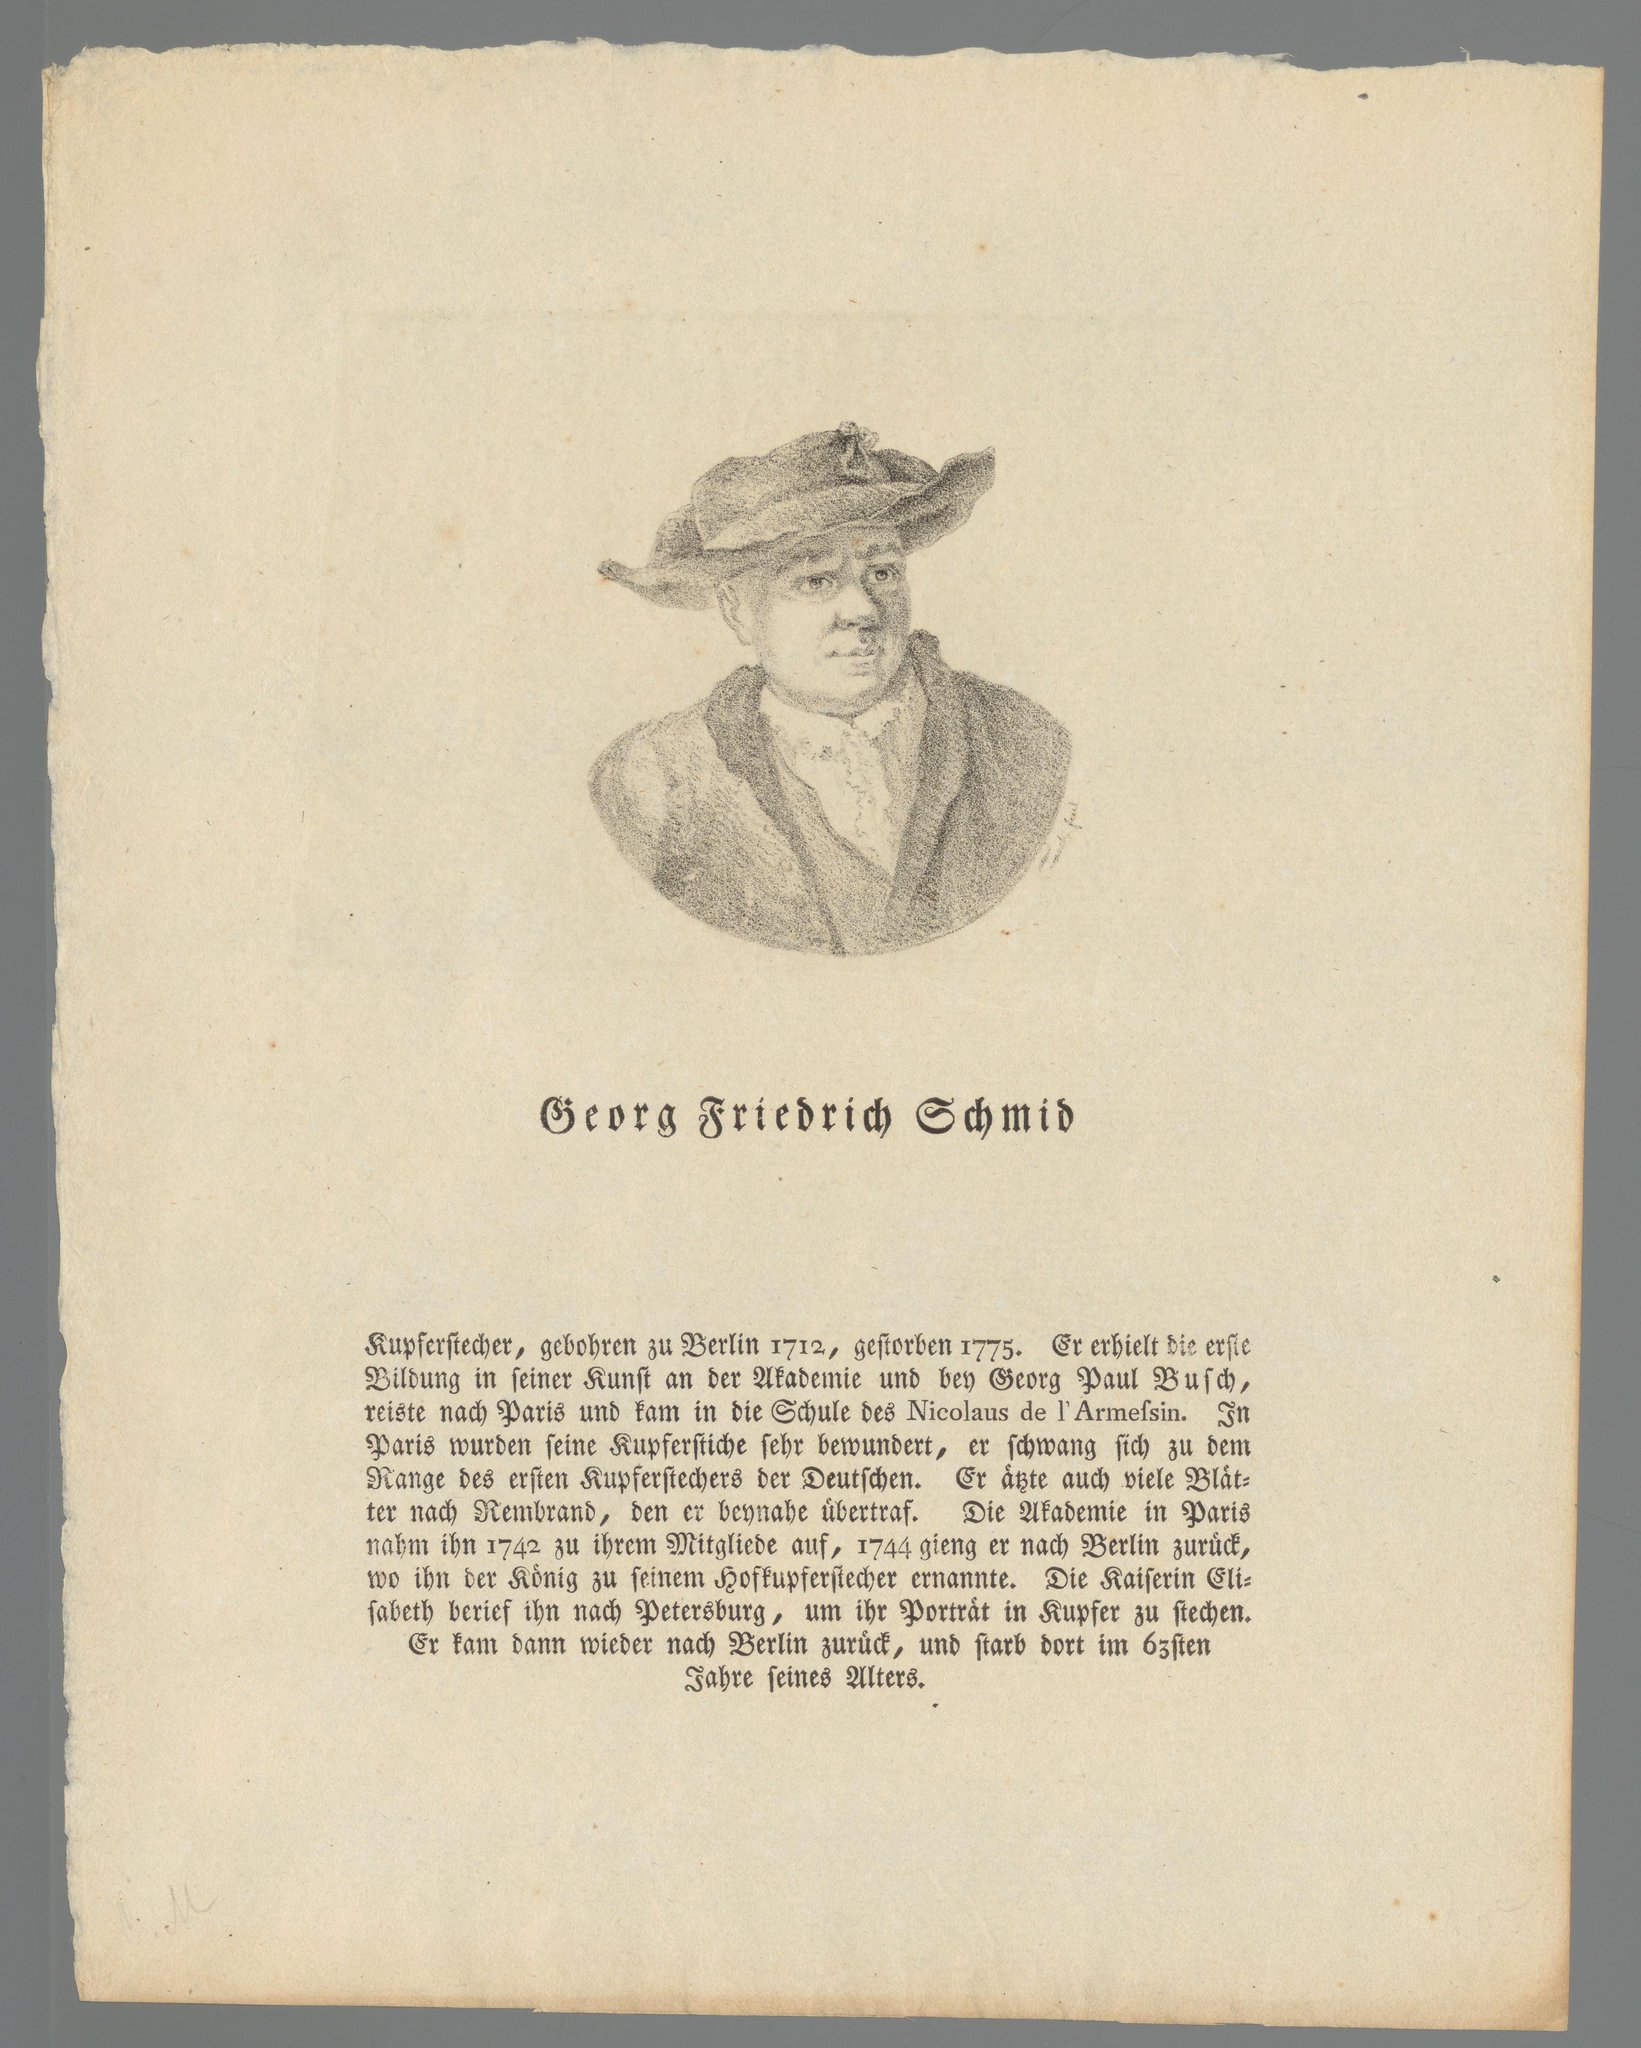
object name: print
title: Portret van Georg Friedrich Schmidt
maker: maximilian franck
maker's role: print maker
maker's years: 1780-1830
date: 1813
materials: paper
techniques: letterpress printing, lithograph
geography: munich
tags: berlin, print maker, draughtsman, georg friedrich schmidt, historical persons, portrait, self-portrait of graphic artist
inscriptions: collector's mark: Lugt 2228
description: Prent uit: Lindauer, Joseph. Deutsche Künstler-Gallerie. München: Maximilian Franck, 1813.